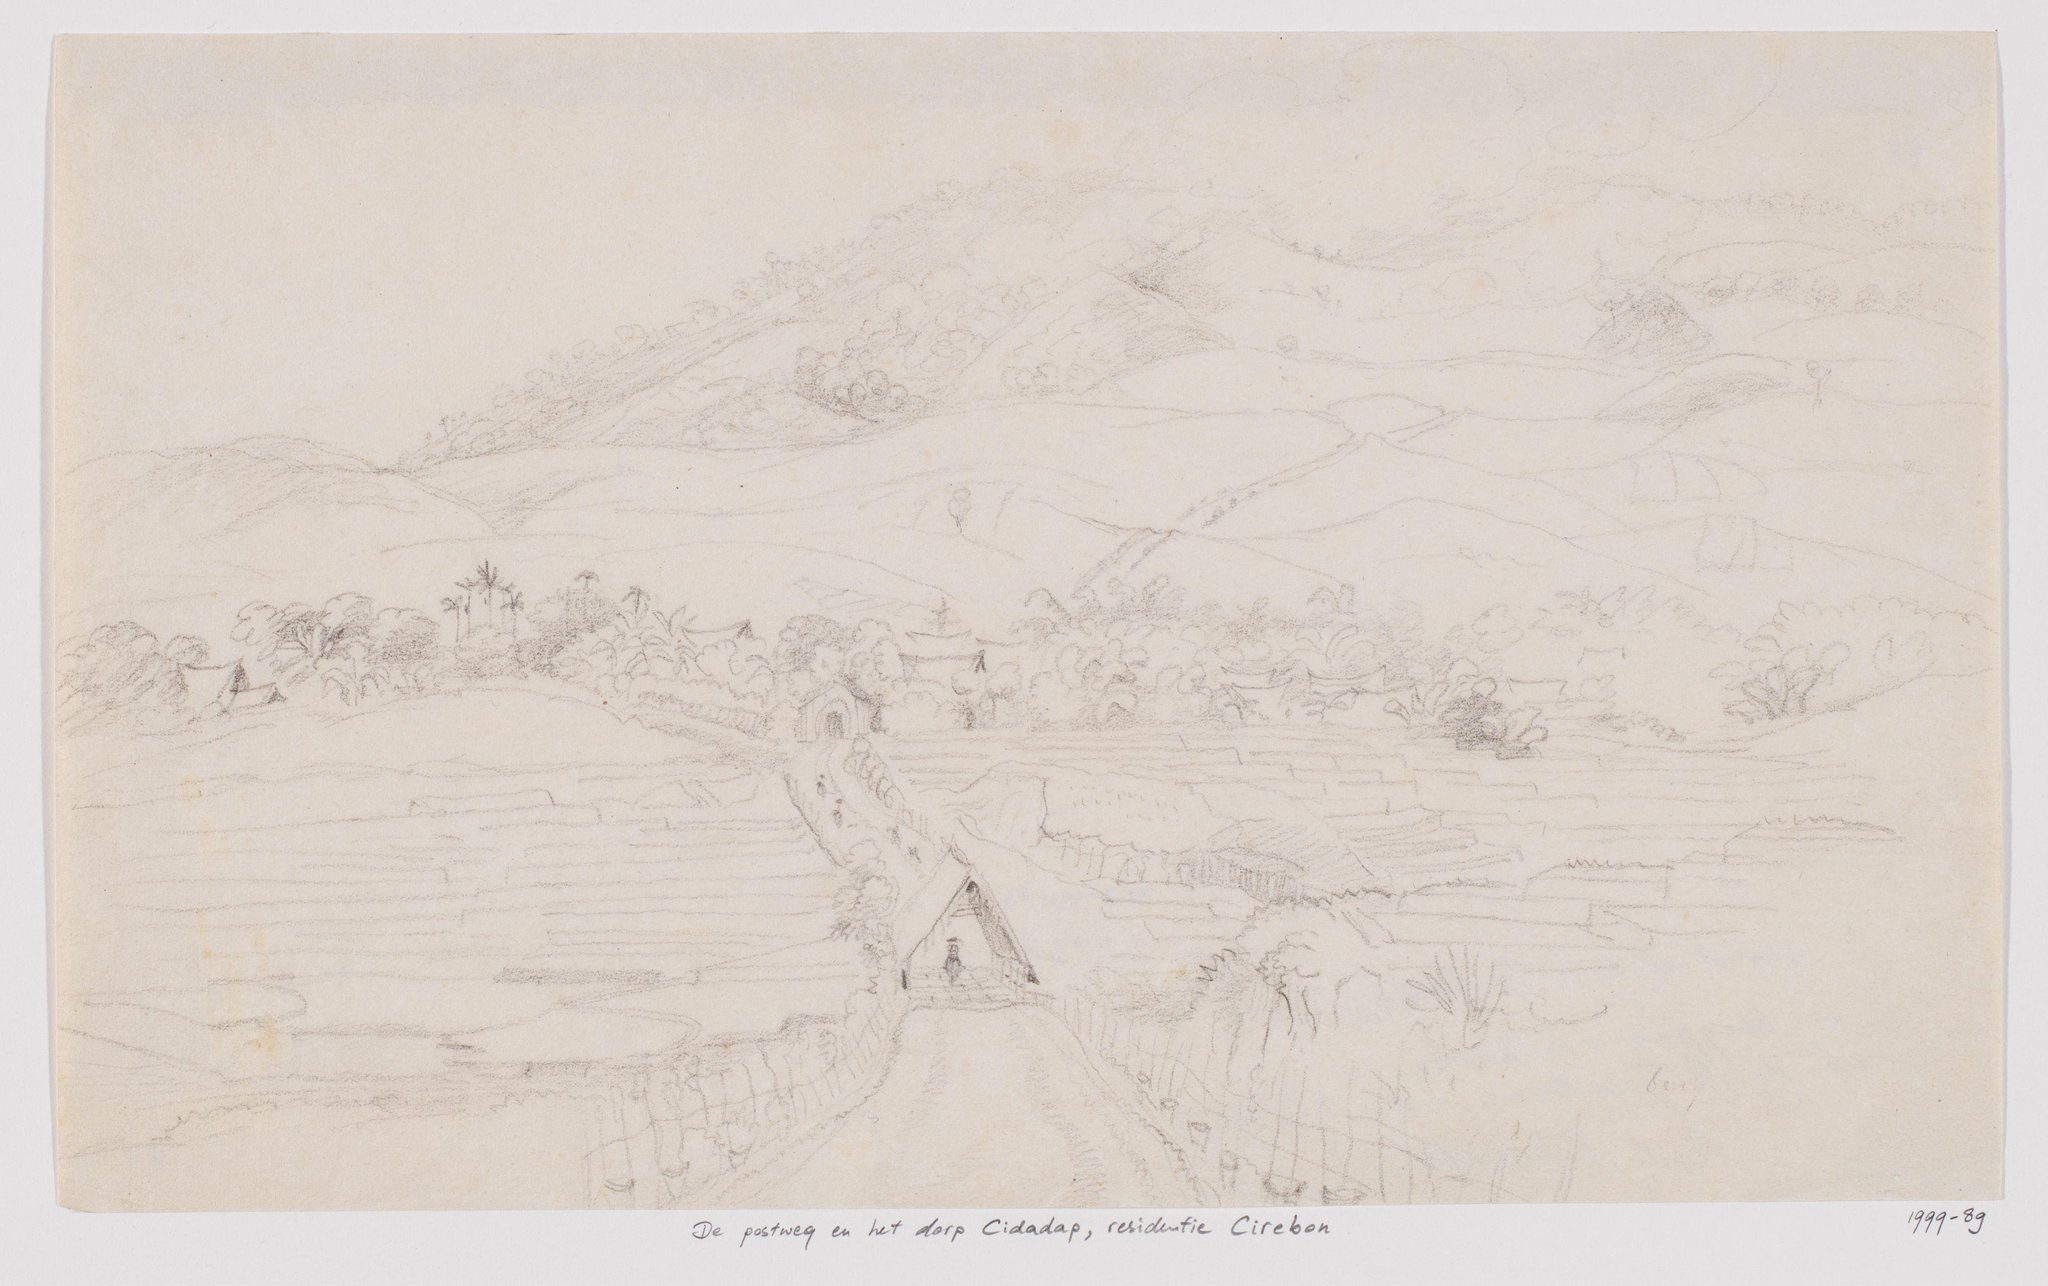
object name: drawing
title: Gezicht op postweg en dorp Cidadap; residentie Cirebon, West-Java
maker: adrianus johannes bik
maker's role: draughtsman, print maker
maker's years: 1790-1872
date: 1836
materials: paper, pencil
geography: west java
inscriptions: date: ‘14 Feb. / 1836’, annotation: ‘gezigt op de k.[i.e.kampung] Tjidadap/ en bergpas van Telaga/ over de G.[i.e. gunung] Tjandana [Cendana] naar Pendjala [Panjalu]/ res. Cheribon’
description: artikel over deze collectie in Bulletin van het Rijksmuseum 49 [2001], nr. 4, pp 342 e.v.